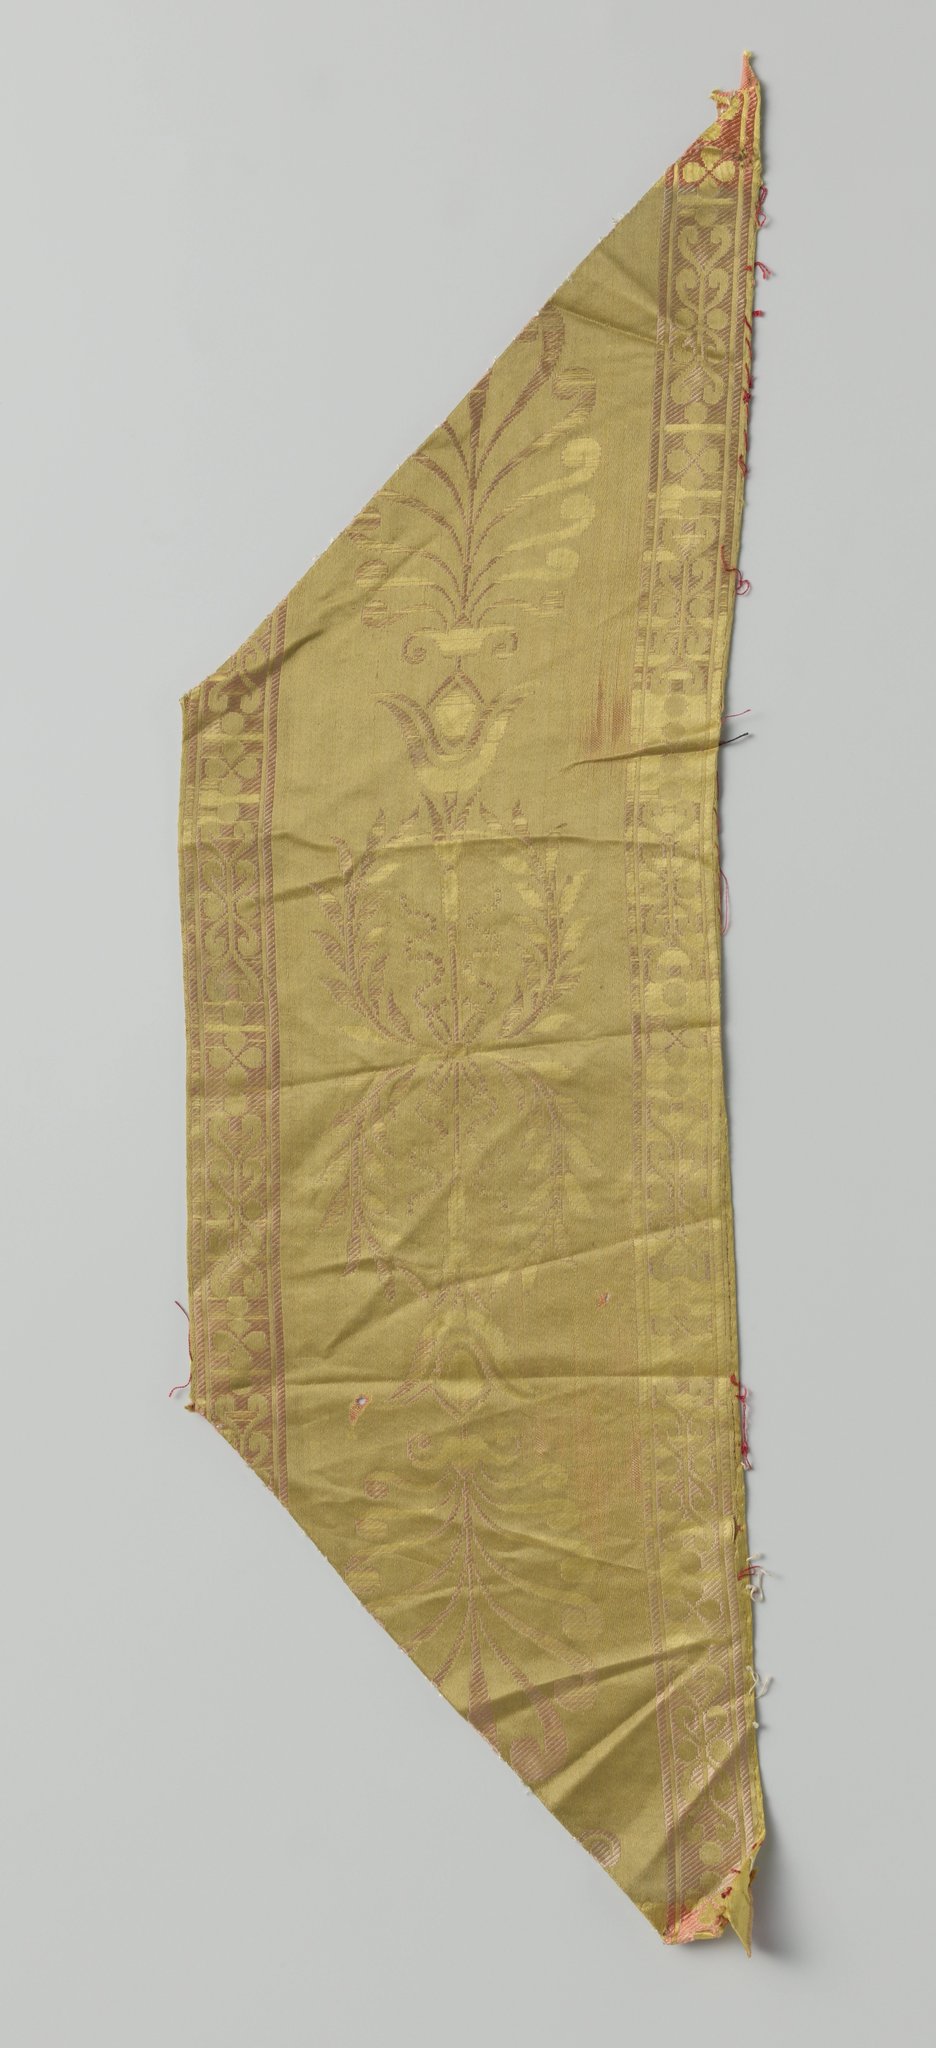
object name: stoelbekleding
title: Fragment zijdeweefsel van een stoelbekleding.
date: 1805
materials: silk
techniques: brocade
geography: france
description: Fragment geel zijdeweefsel, van een stoelbekleding. Het patroon heeft op een gele grond roze palmetten en arabesken. Het fragment hoort bij dertien fragmenten met invnr. BK-1992-18-A t/m BK-1992-18-M.